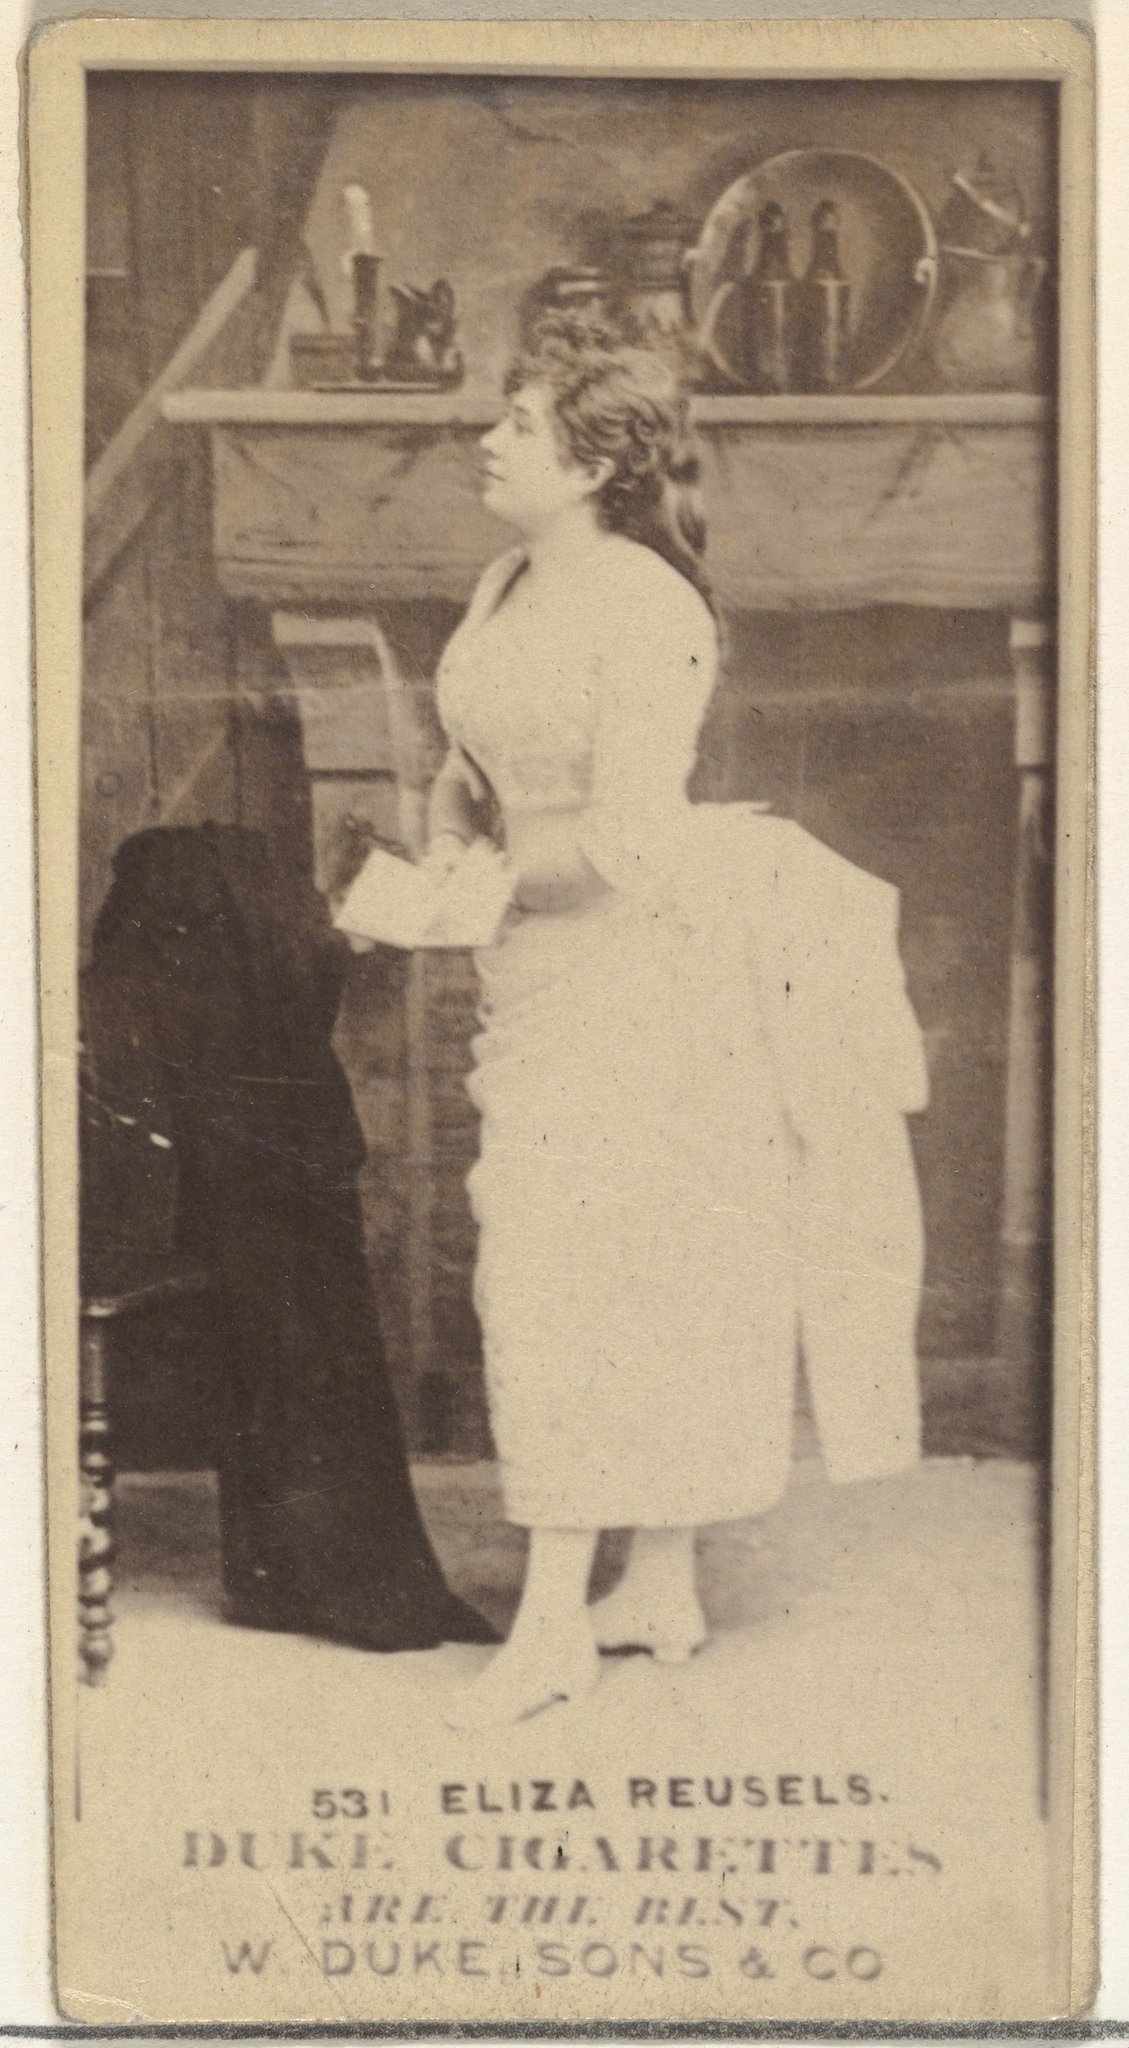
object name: photograph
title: Card Number 531, Eliza Reusels, from the Actors and Actresses series (N145-7) issued by Duke Sons & Co. to promote Duke Cigarettes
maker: w. duke, sons & co.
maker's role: publisher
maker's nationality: american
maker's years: 1870-1920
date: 1880-1889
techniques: albumen silver print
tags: women,actresses